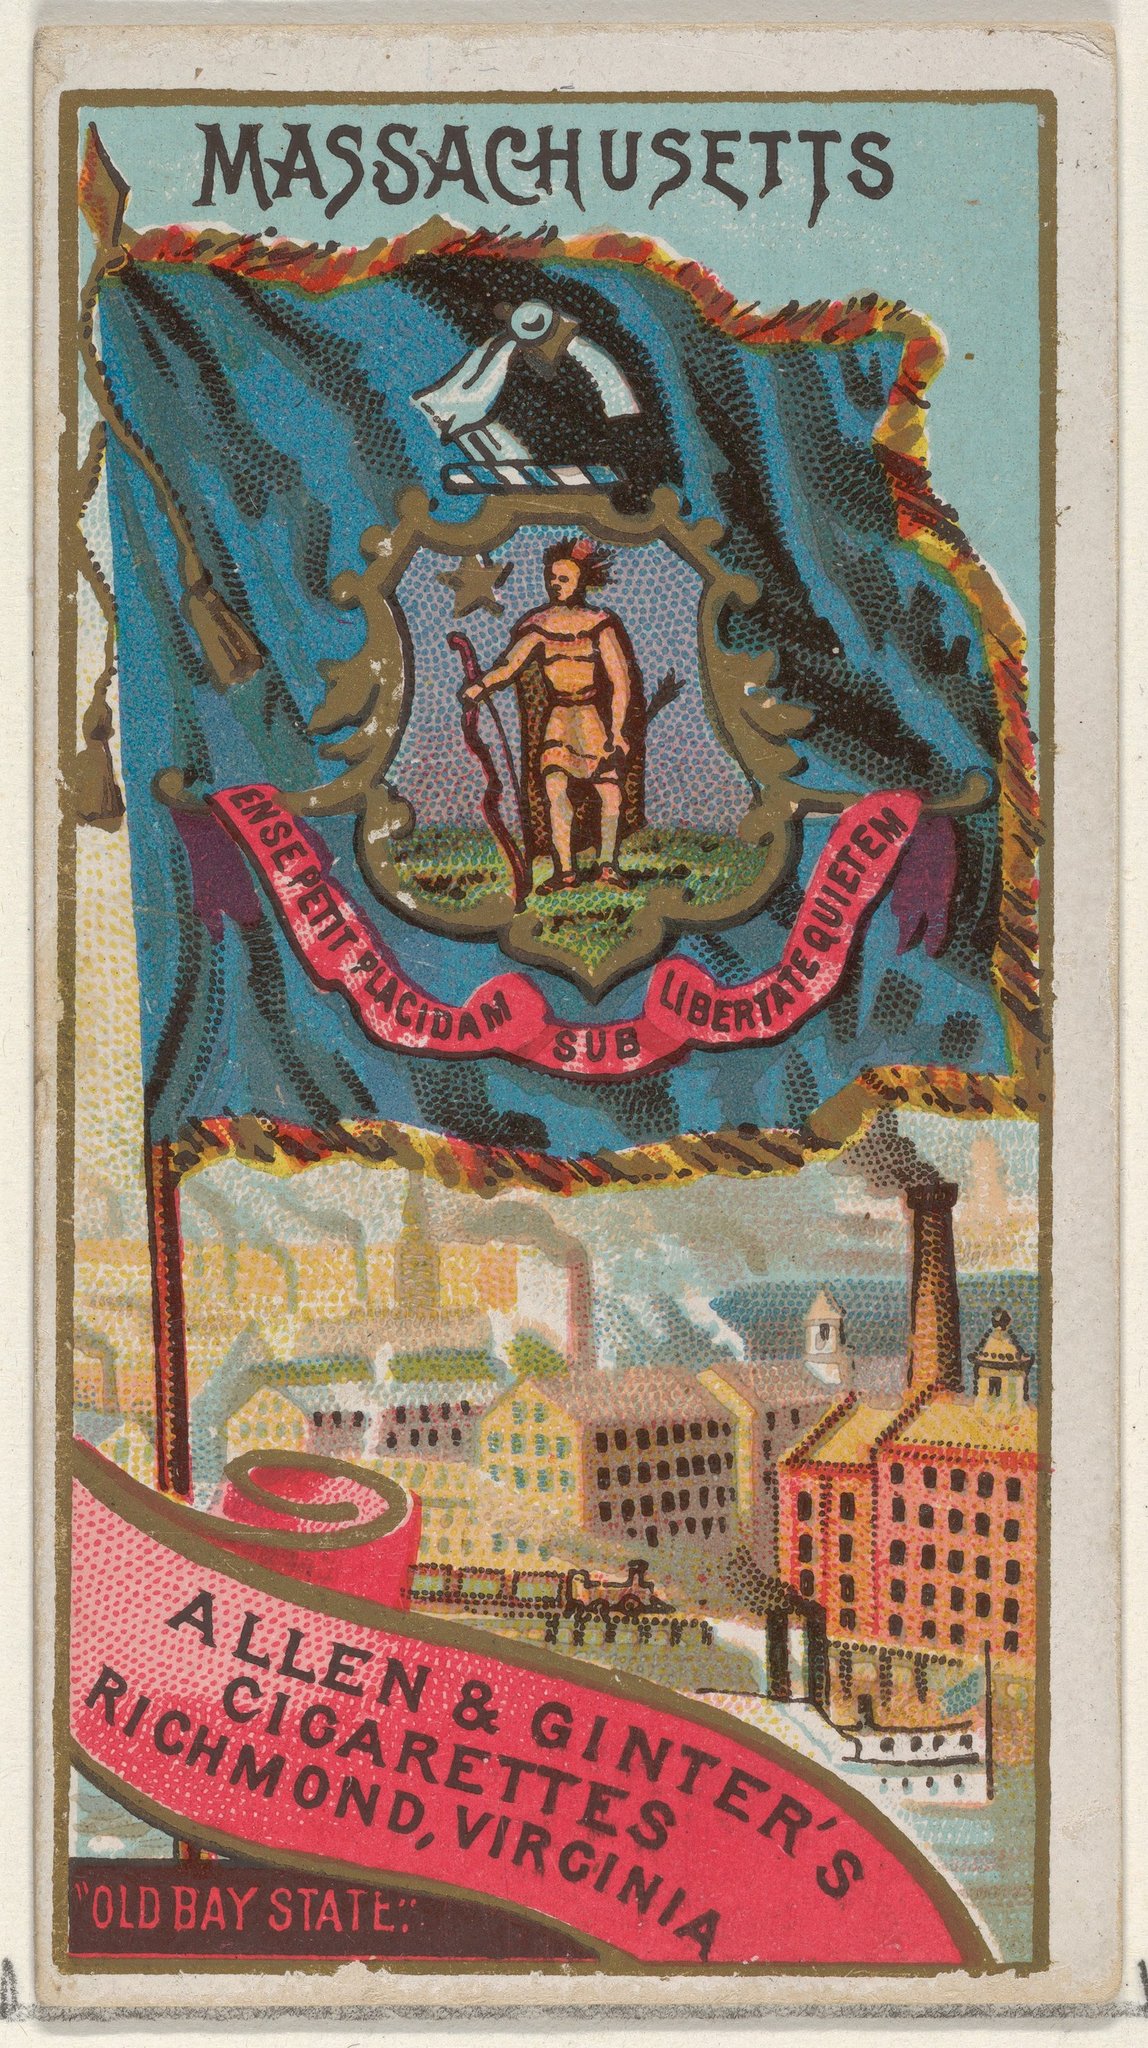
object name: print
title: Massachusetts, from Flags of the States and Territories (N11) for Allen & Ginter Cigarettes Brands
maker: allen & ginter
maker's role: publisher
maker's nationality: american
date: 1888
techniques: color lithograph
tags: coat of arms